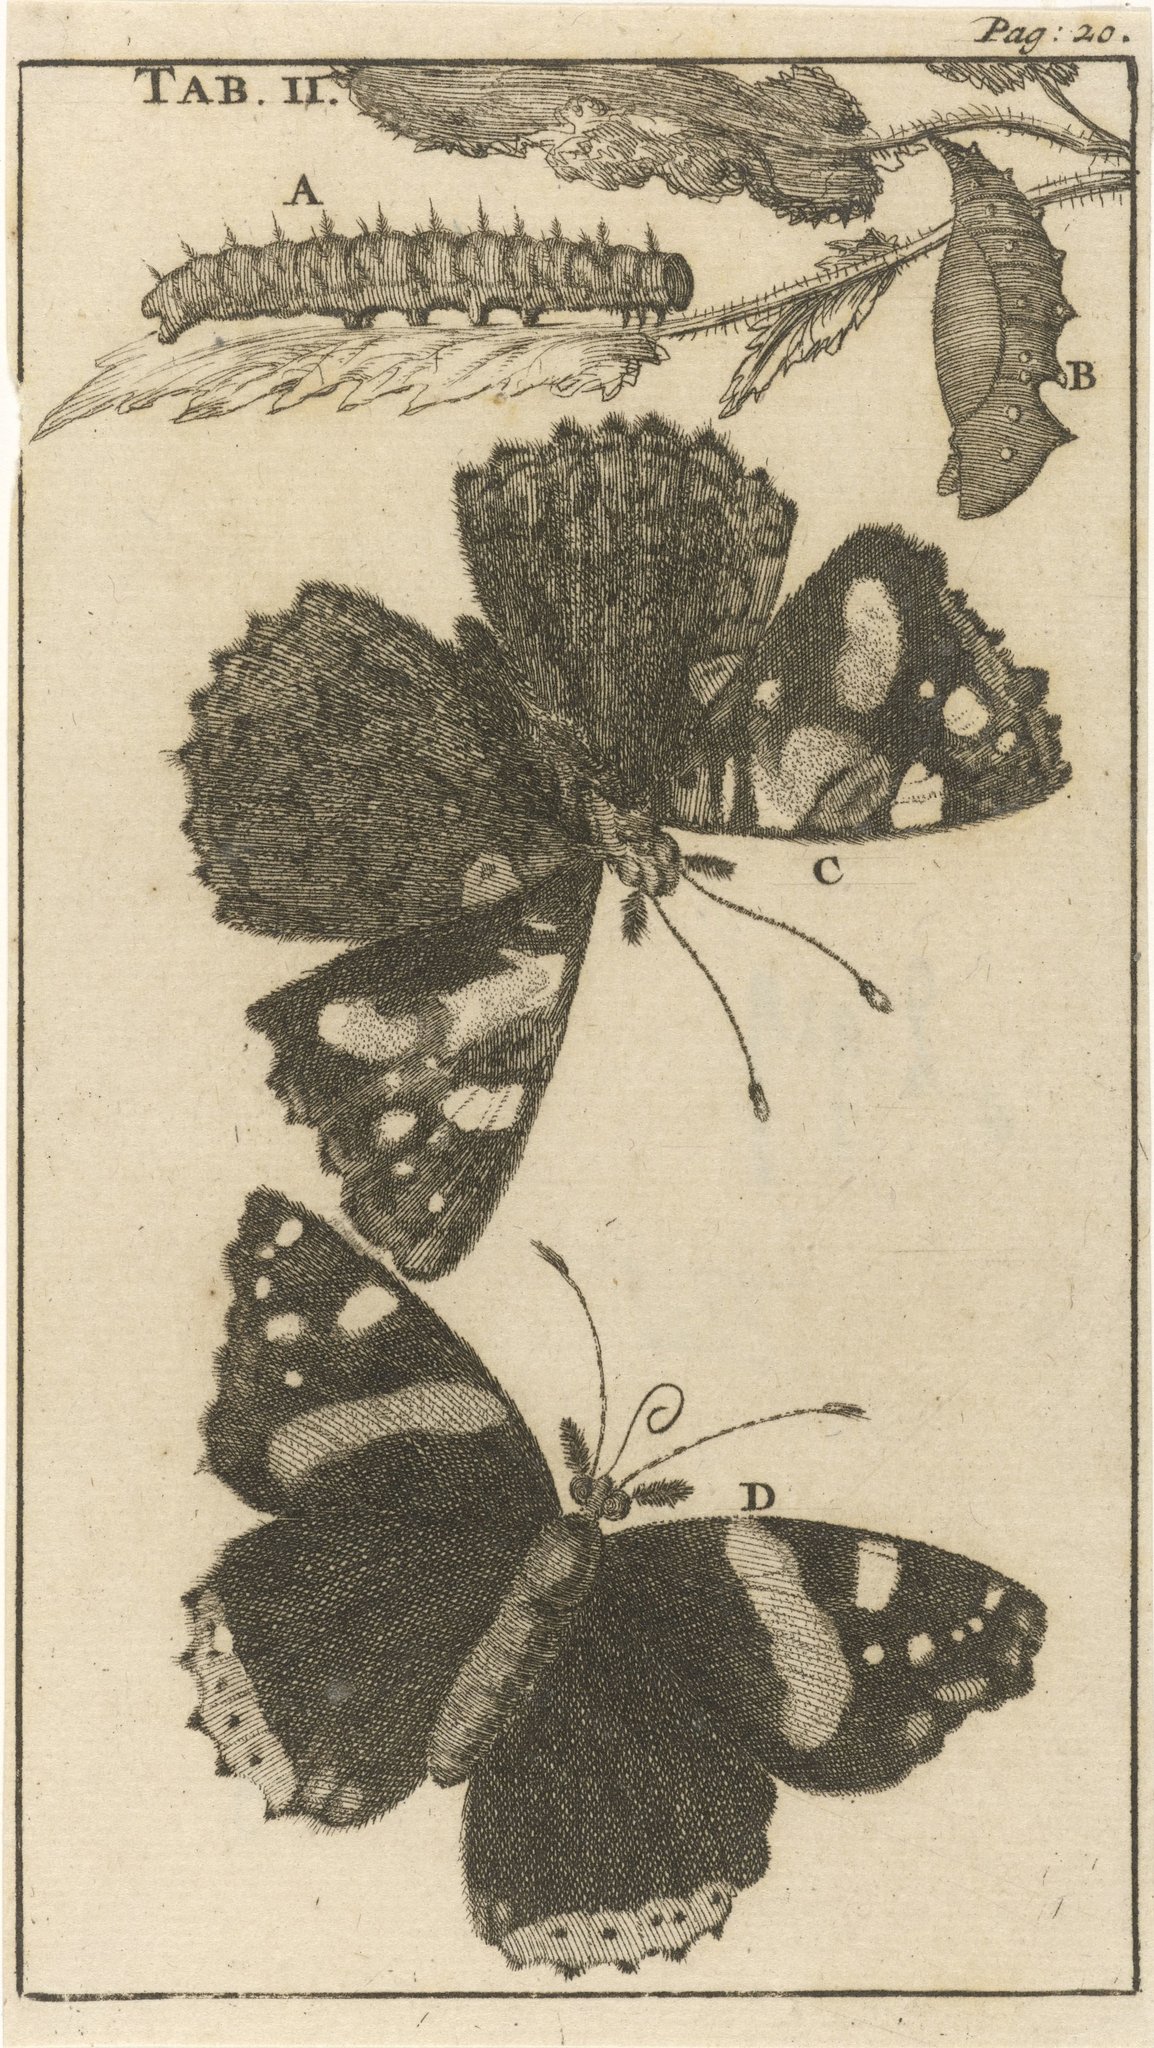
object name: book illustration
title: Rupsen, poppen en vlinders II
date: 1680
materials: paper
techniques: etching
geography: amsterdam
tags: insects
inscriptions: collector's mark: Lugt 2228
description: Illustratie opgenomen in: Blankaart, Steven. Schou-burg der rupsen, wormen, ma'den, en vliegende dierkens daar uit voortkomende. Amsterdam: Jan Claesz ten Hoorn, 1680.